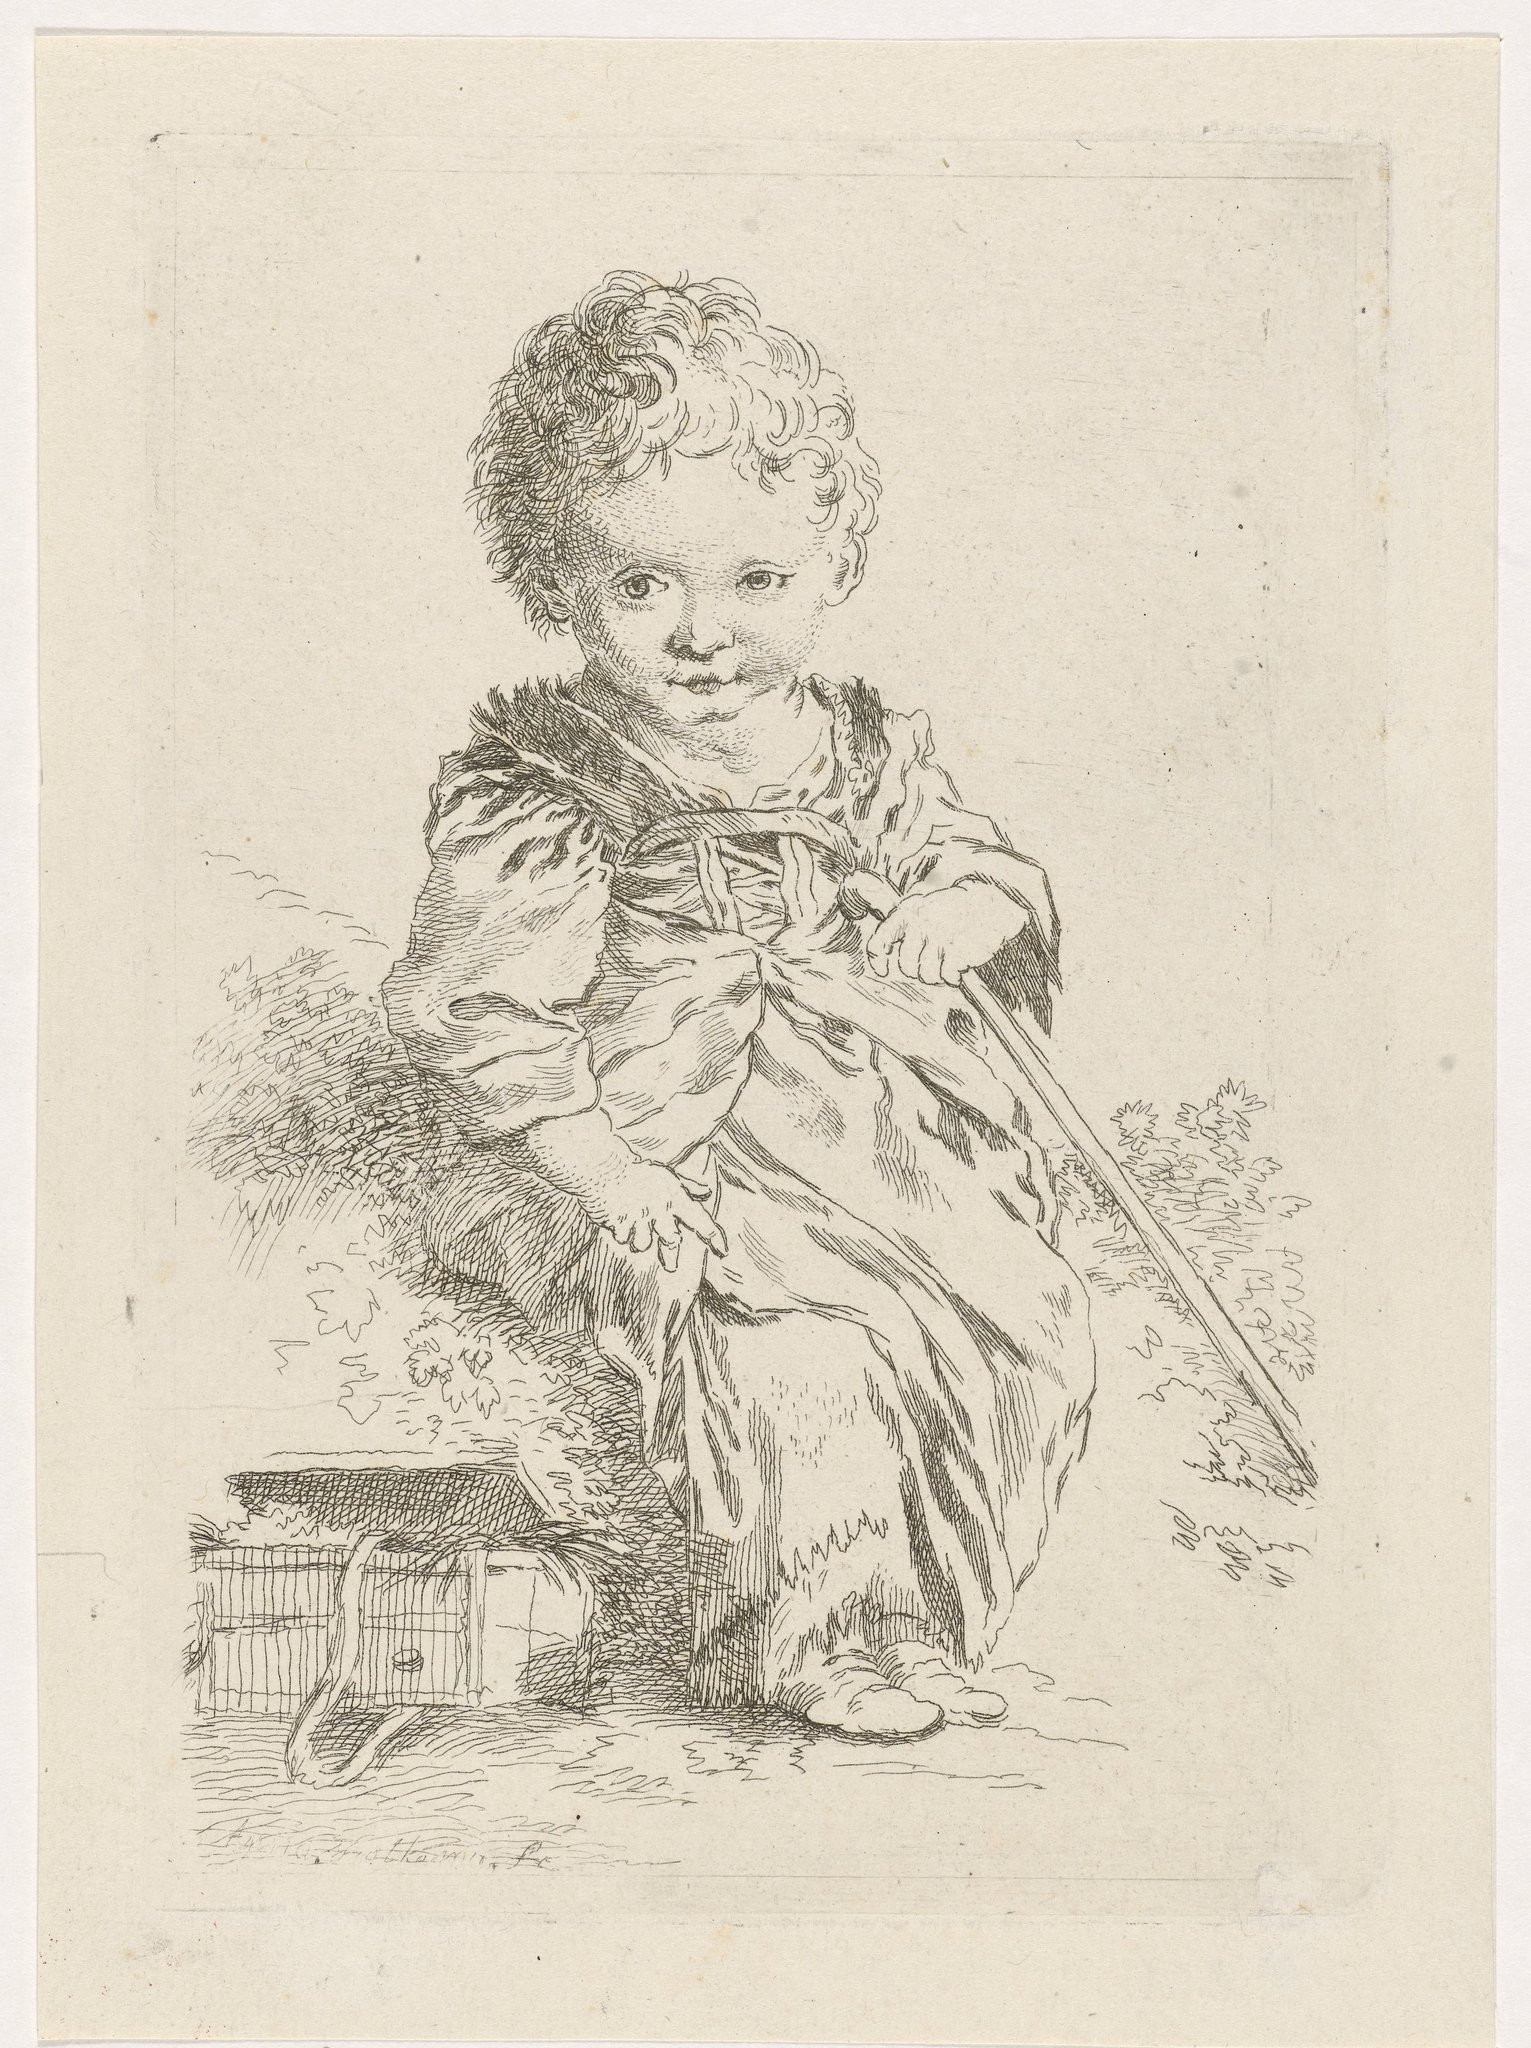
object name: print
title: Jongetje met wandelstok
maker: anna folkema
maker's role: draughtsman, print maker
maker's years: 1695-1768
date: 1705-1768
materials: paper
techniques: etching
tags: walking-stick, staff, child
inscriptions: collector's mark: Lugt 240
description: Een jongetje zit met een wandelstok in zijn handen in de berm, naast zijn voeten staat een kistje.